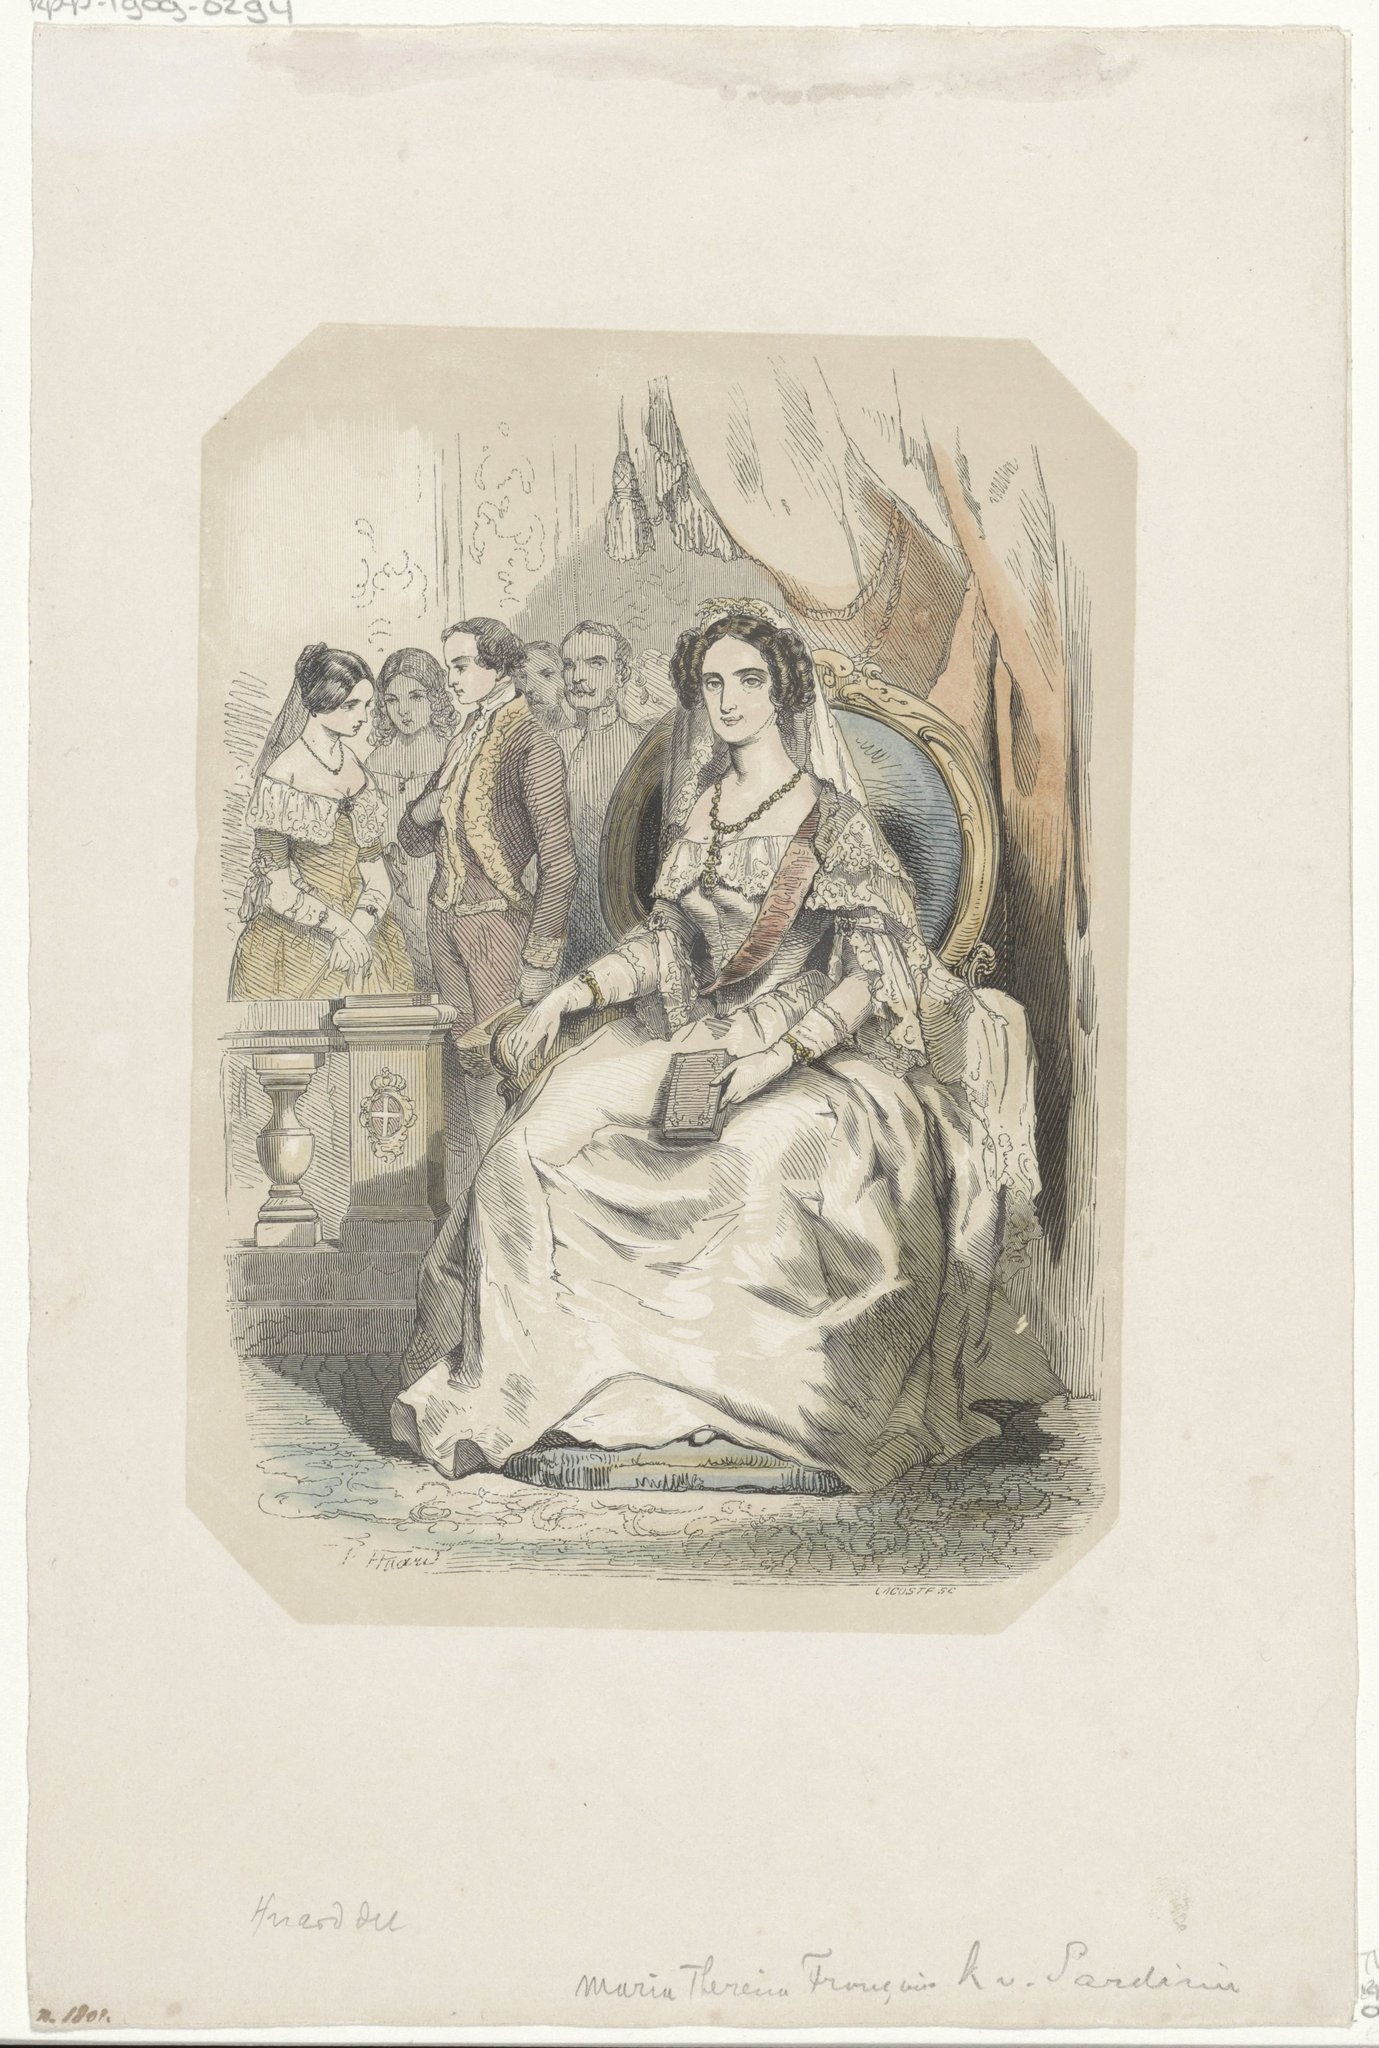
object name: print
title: Portret van Maria Theresia, koningin van Sardinië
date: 1852-1869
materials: paper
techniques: hand coloring, engraving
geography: netherlands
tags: rome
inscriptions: collector's mark: Lugt 2228